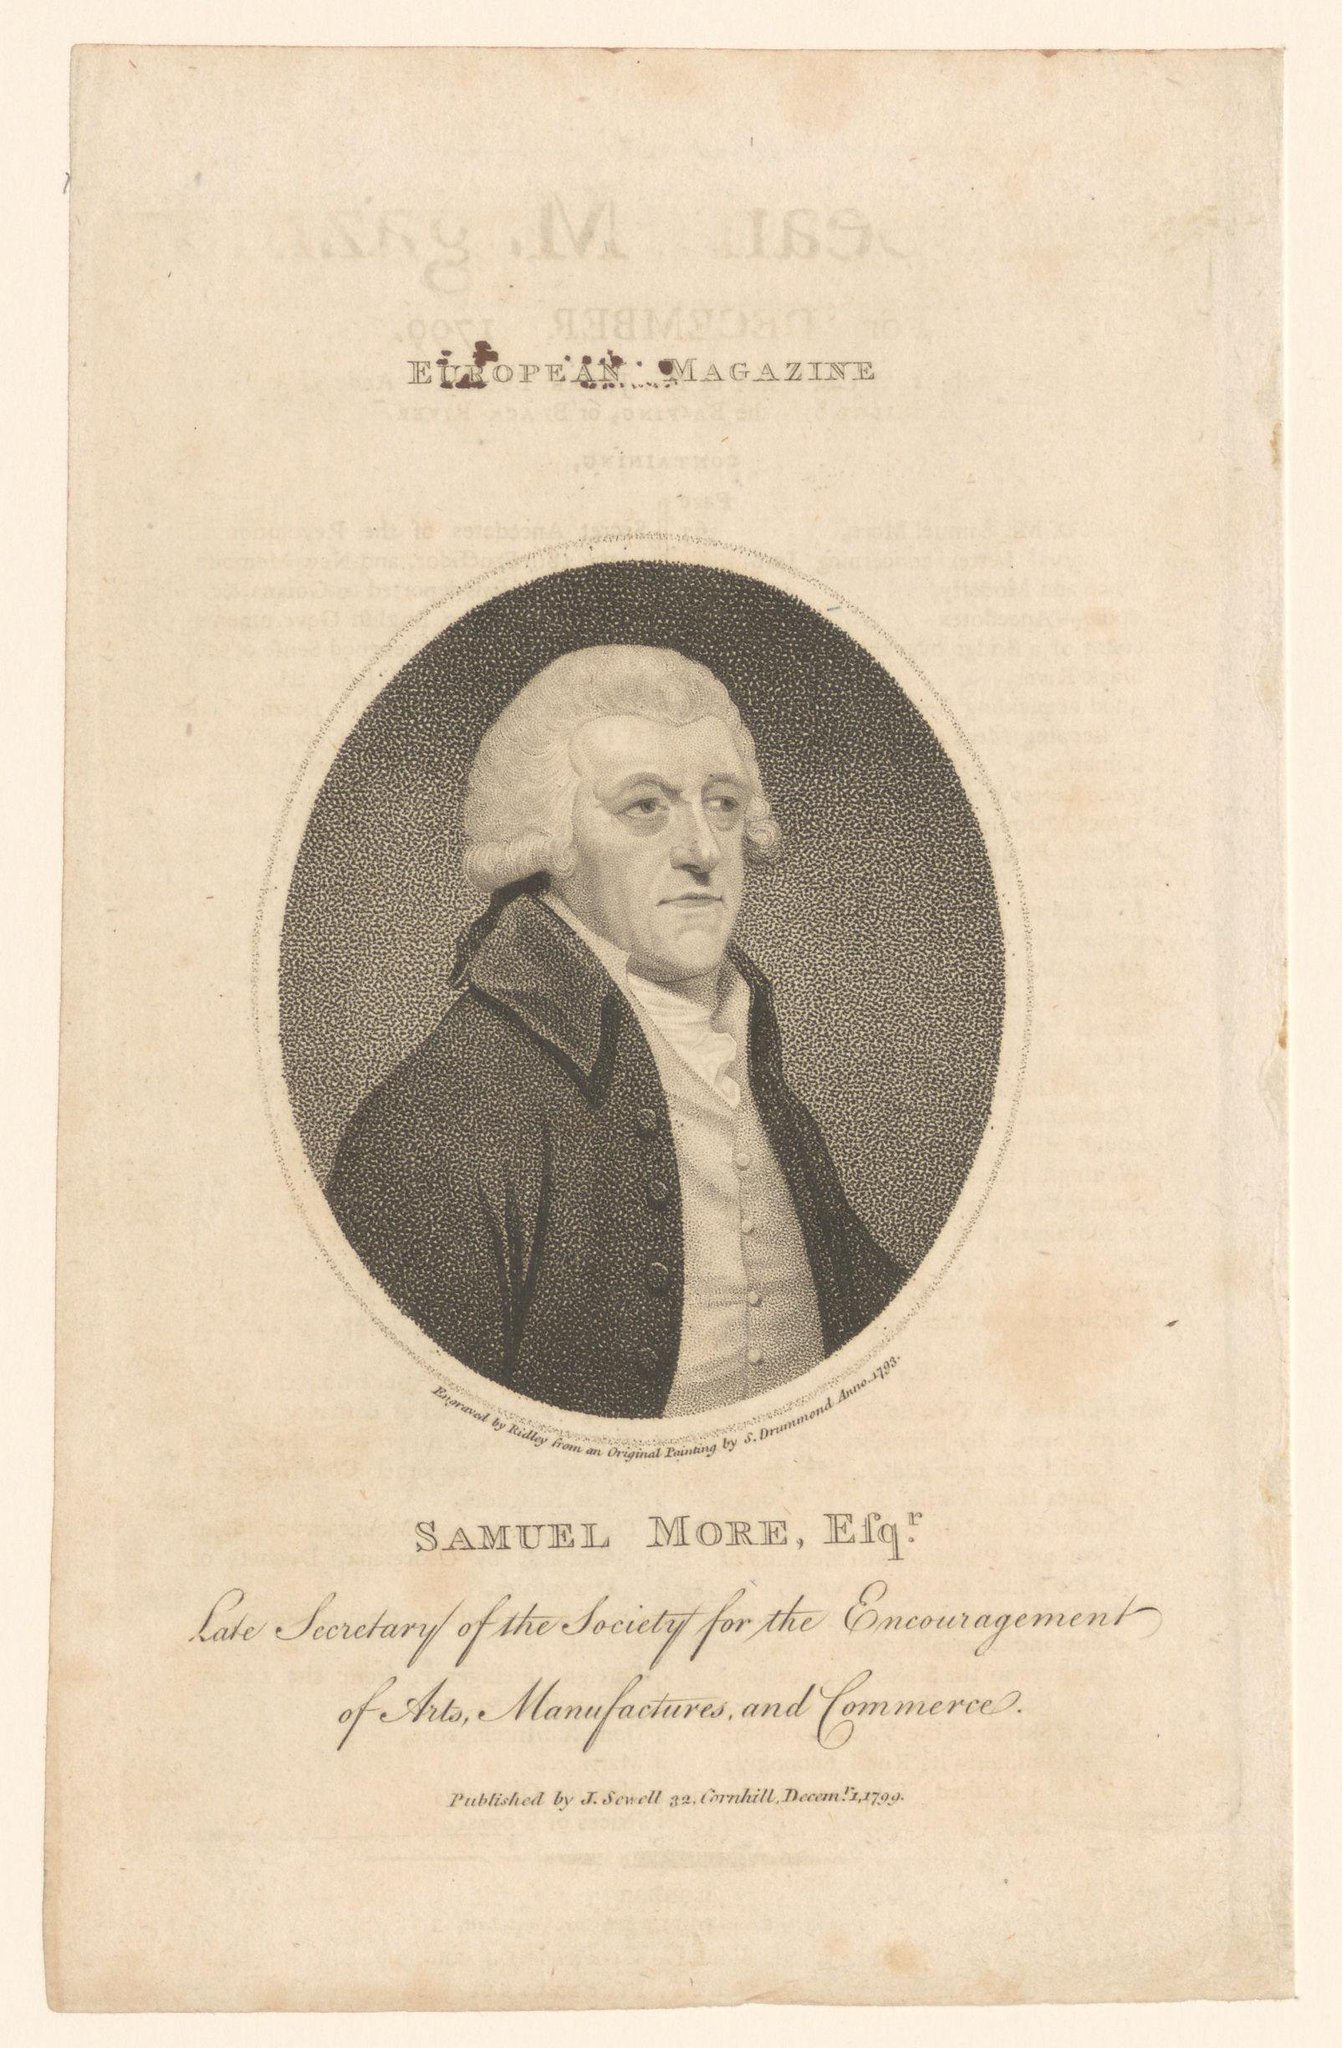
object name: print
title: Portret van Samuel More Esqr.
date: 1793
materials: paper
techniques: stippling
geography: london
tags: historical persons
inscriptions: collector's mark: Lugt 2228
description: Prent gebruikt in: European Magazine (1799).